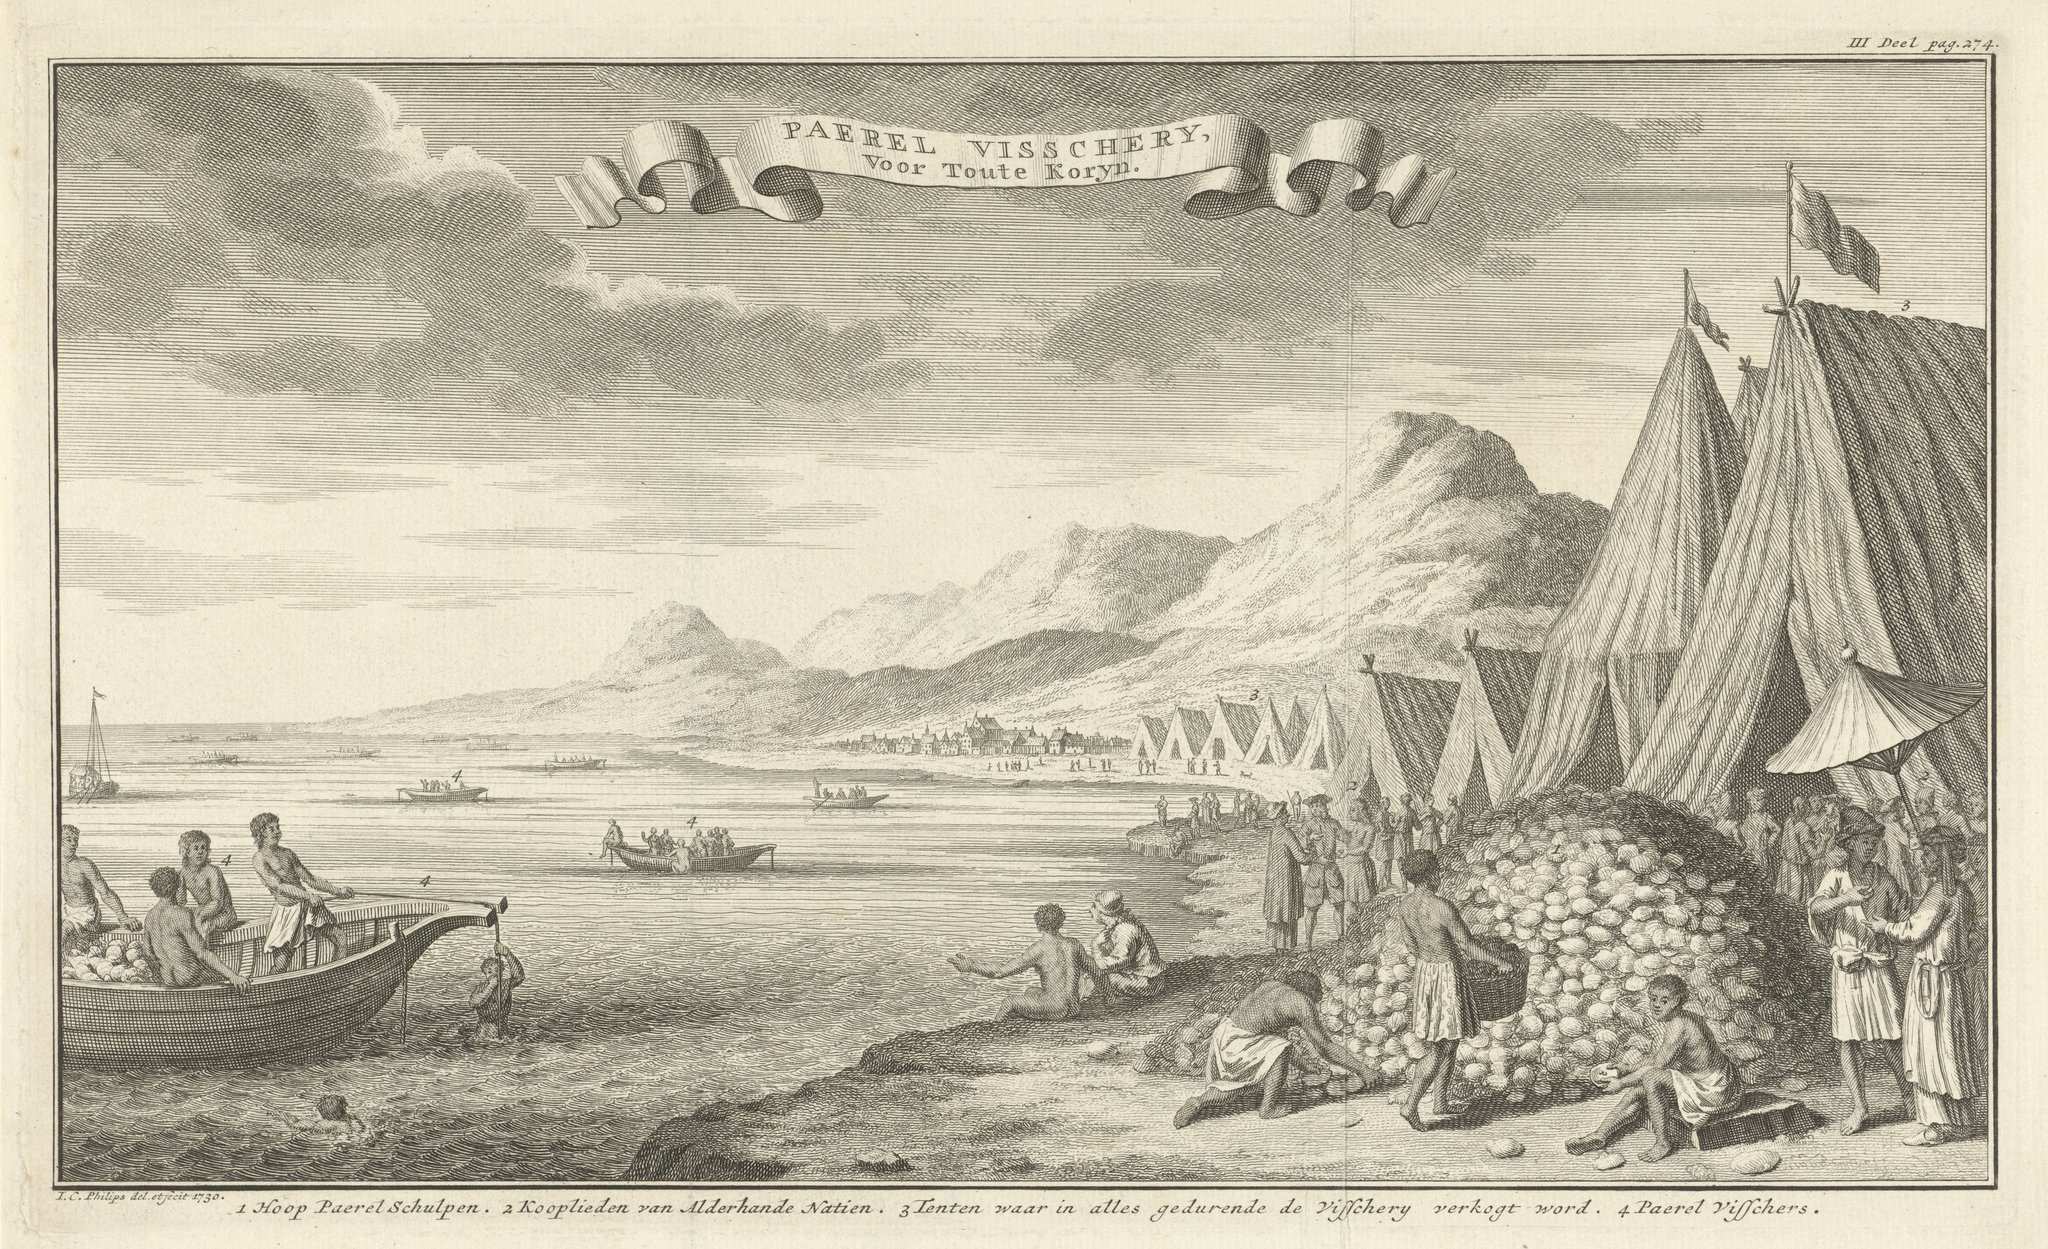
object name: book illustration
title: Parelvissers voor Tutecorin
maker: jan caspar philips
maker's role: draughtsman, print maker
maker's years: 1700-1775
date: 1730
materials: paper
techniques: etching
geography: amsterdam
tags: asiatic races and peoples, pearl fishing, pearl diving; coral fishing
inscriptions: collector's mark: Lugt 2228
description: Illustratie uit: Salmon, Thomas. Hedendaagsche historie, of Tegenwoordige staat van alle volkeren (...) III. deel. Behelzende (...) India (...) Malabar, Kormandel, en (...) Ceilon. [Vertaald uit het Engels door] M. van Goch. Amsterdam: Isaak Tirion, 1731.